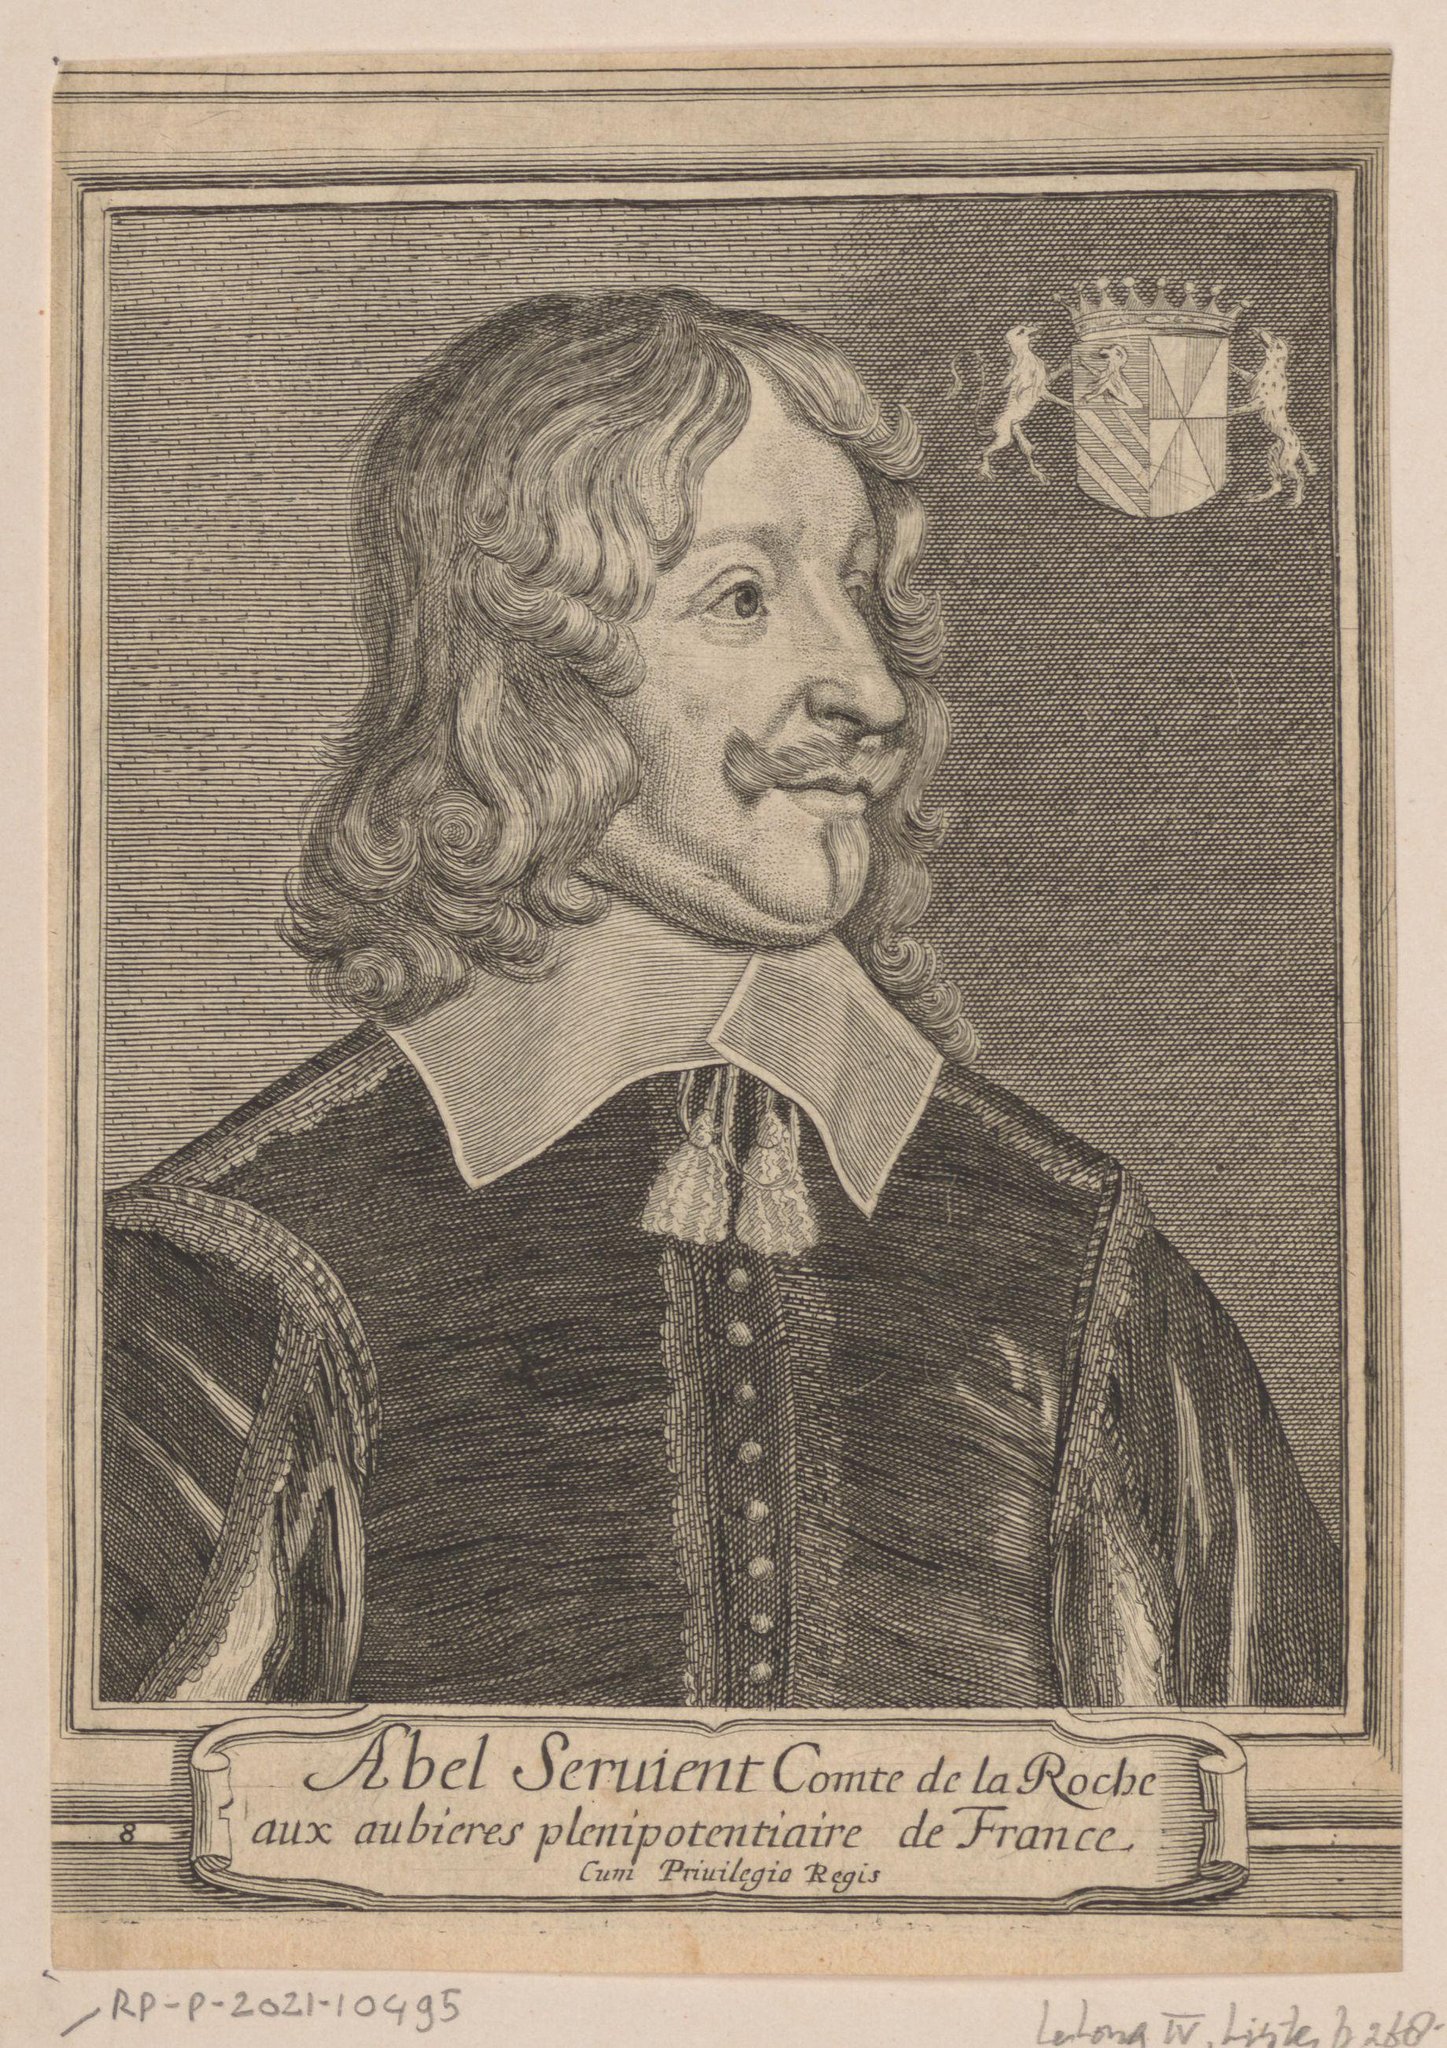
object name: print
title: Portret van Abel de Servien, graaf de la Roche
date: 1648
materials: paper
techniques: engraving, etching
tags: historical persons, negotiations, conference ~ diplomacy, armorial bearing, heraldry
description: Prent waarschijnlijk uit: Legatorum omnium tam Monasterij, quam Osnabrugae (...). Parijs: s.n., 1648. Of uit: Bignon, François. Les portraictz au naturel avec les armoiries et blasons noms et qualitez de messieurs les plénipotentiaires assemblez à Munster et Osnaburg (...). Parijs: Henry Sara en Jean Paslé, [1648].